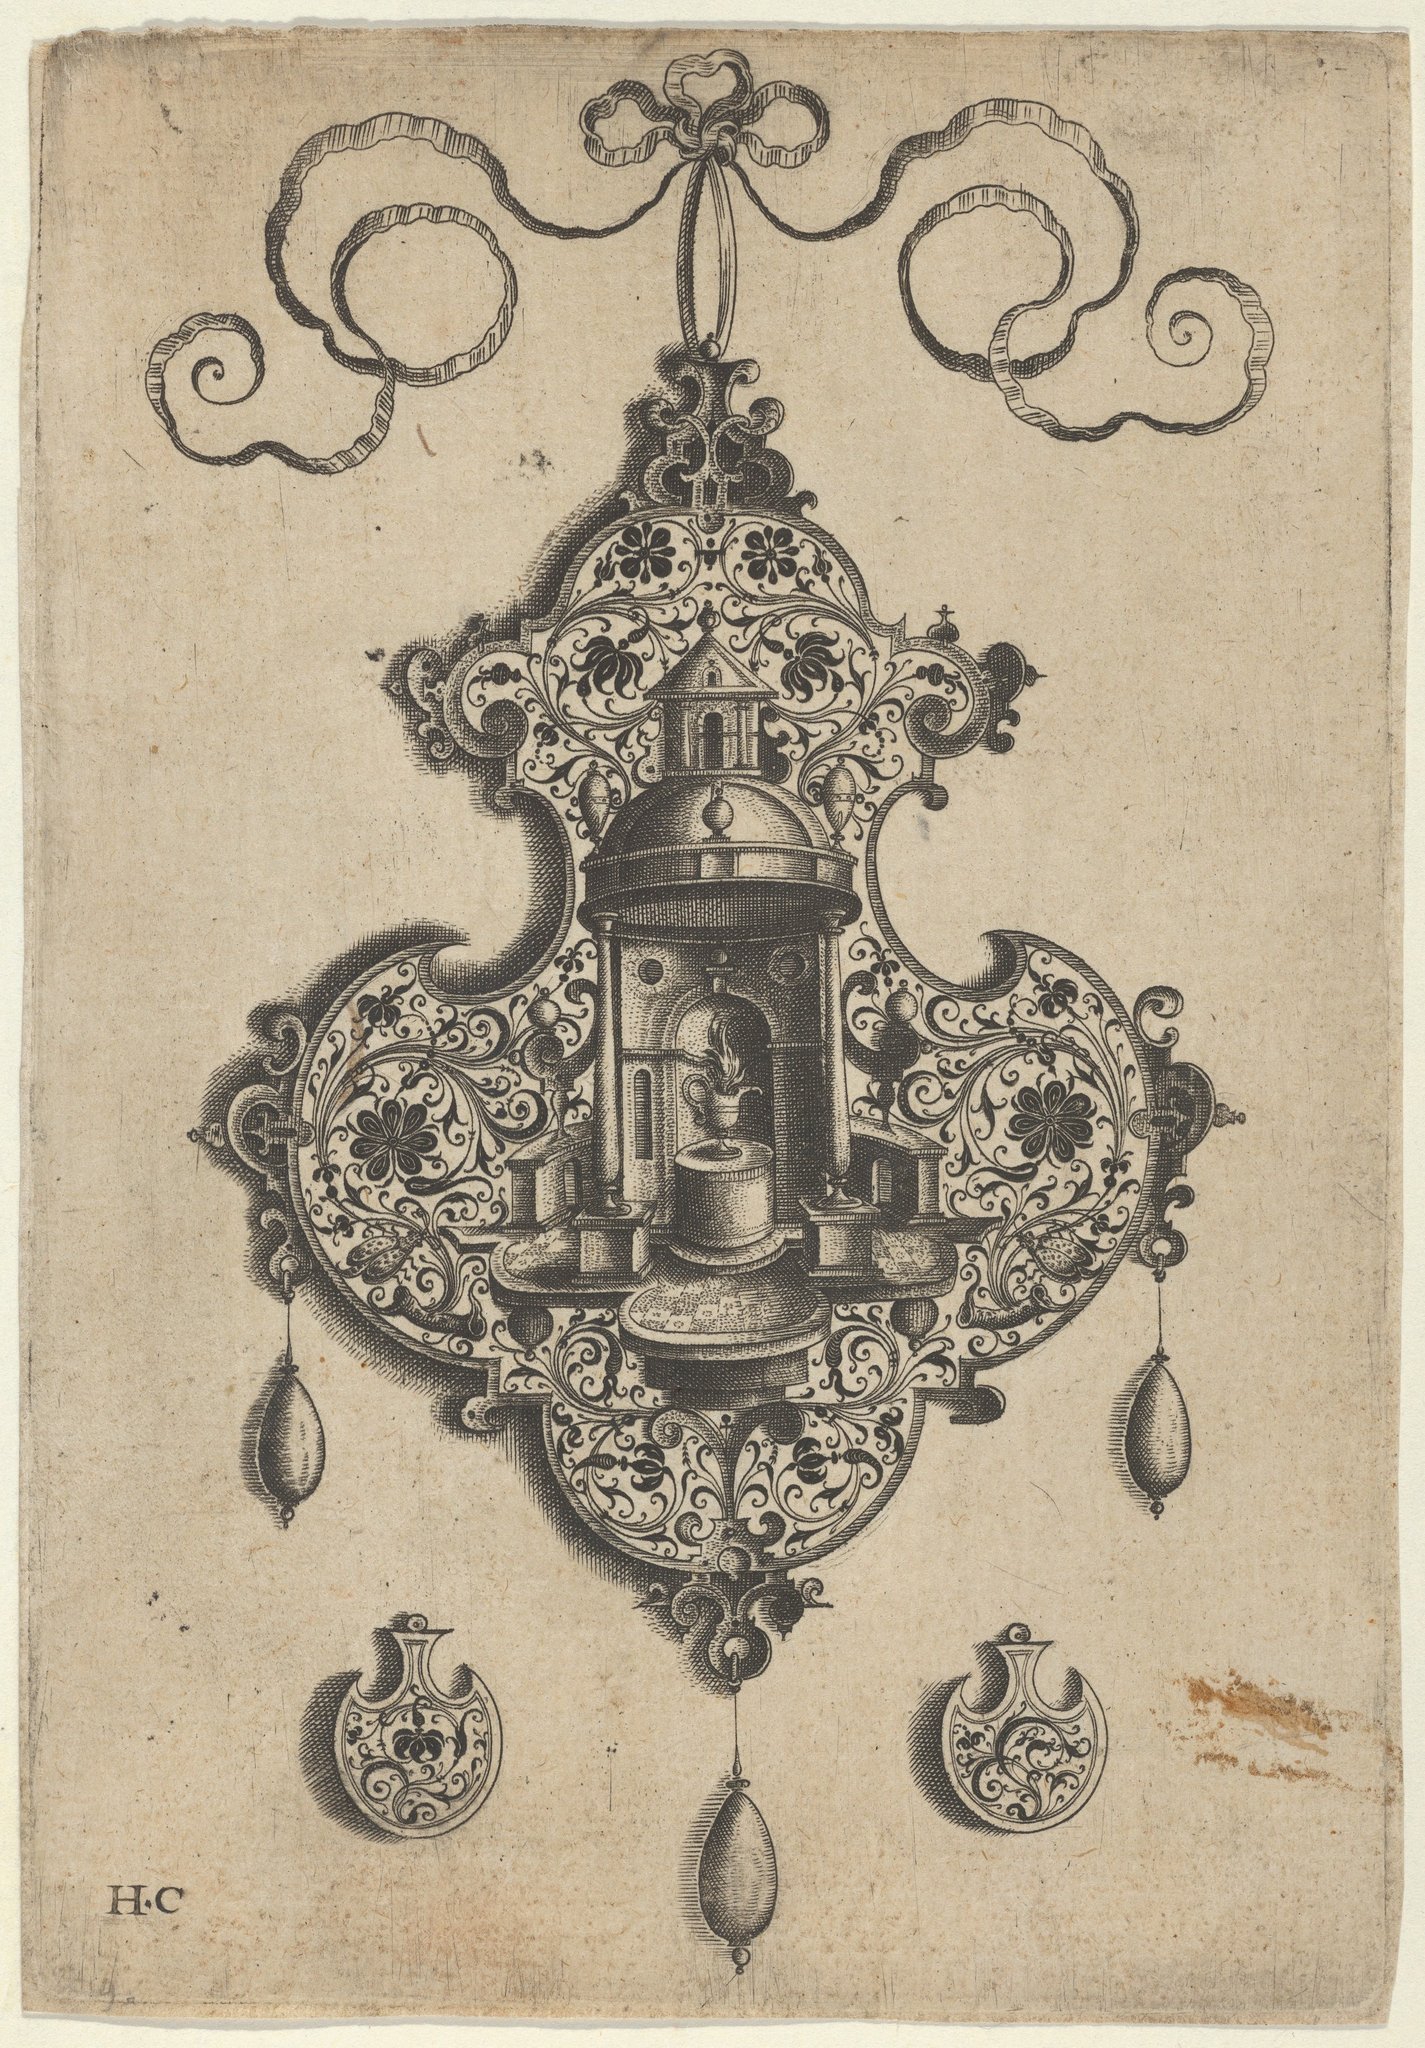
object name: print ornament architecture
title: Pendant Design with a Circular Temple and Burning Pot Above Axe-Shaped Ornaments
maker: jan collaert i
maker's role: artist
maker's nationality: netherlandish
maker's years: 1530-1581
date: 1573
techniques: embroidery, engraving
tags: pendants